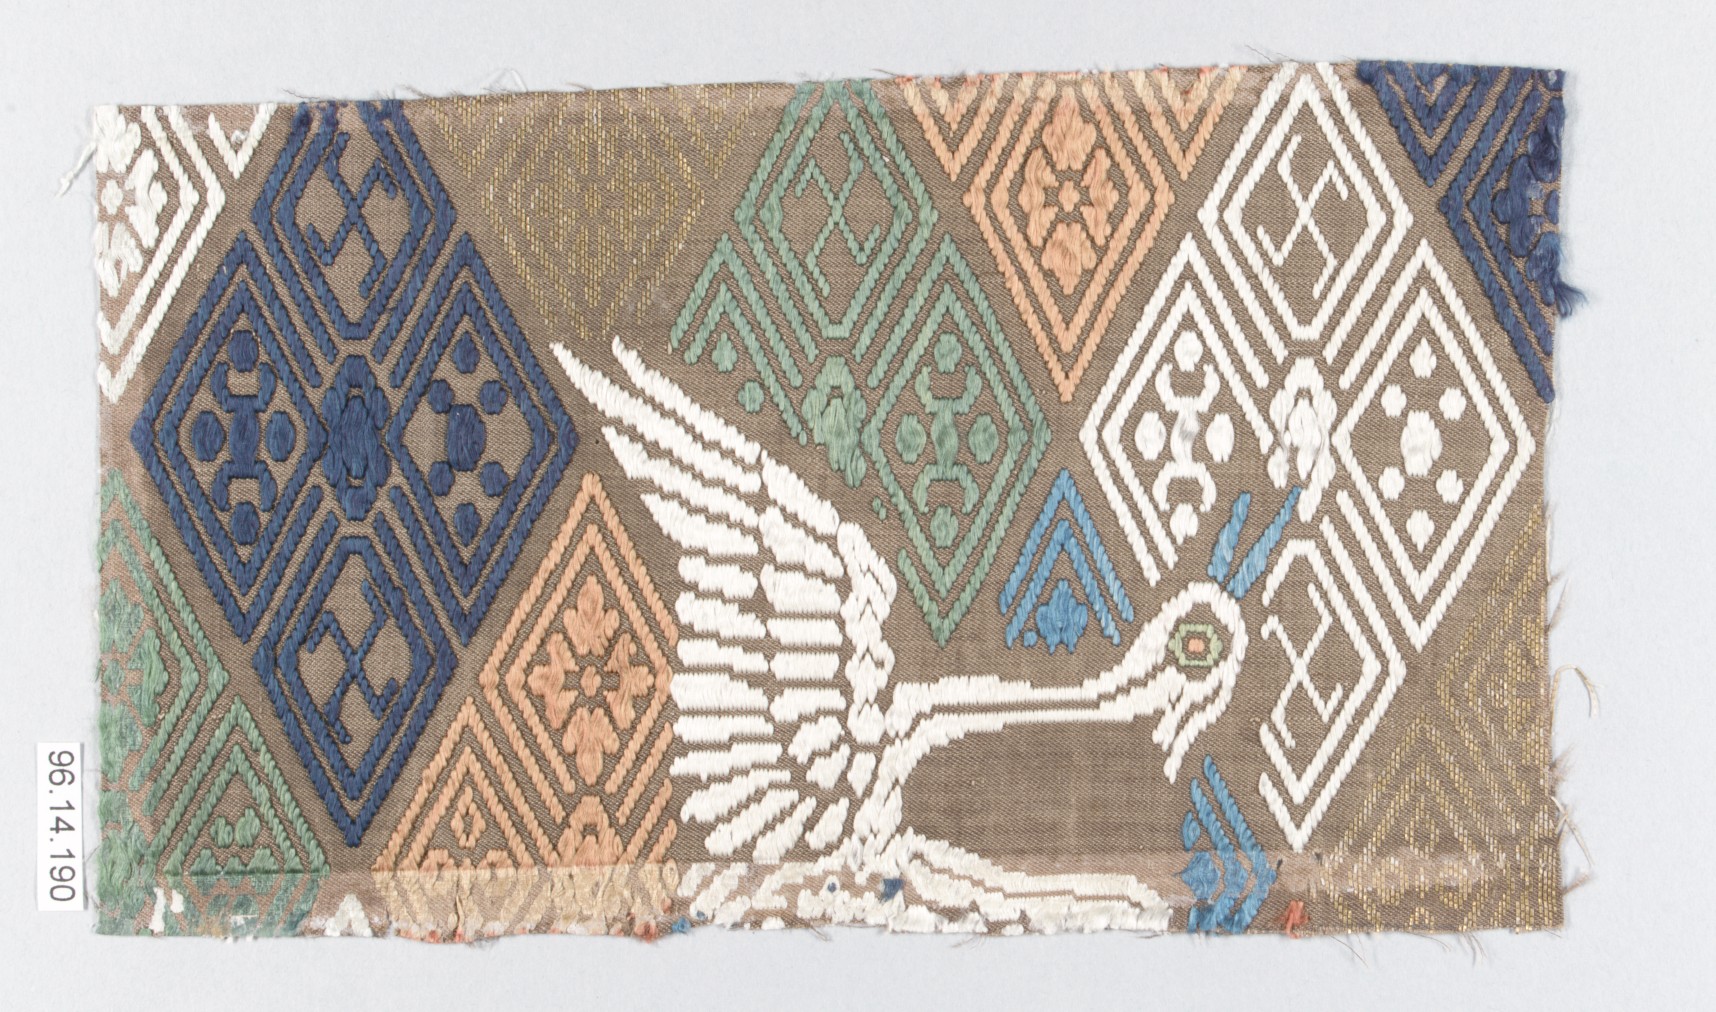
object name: piece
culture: japanese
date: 1701-1800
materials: silk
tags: birds